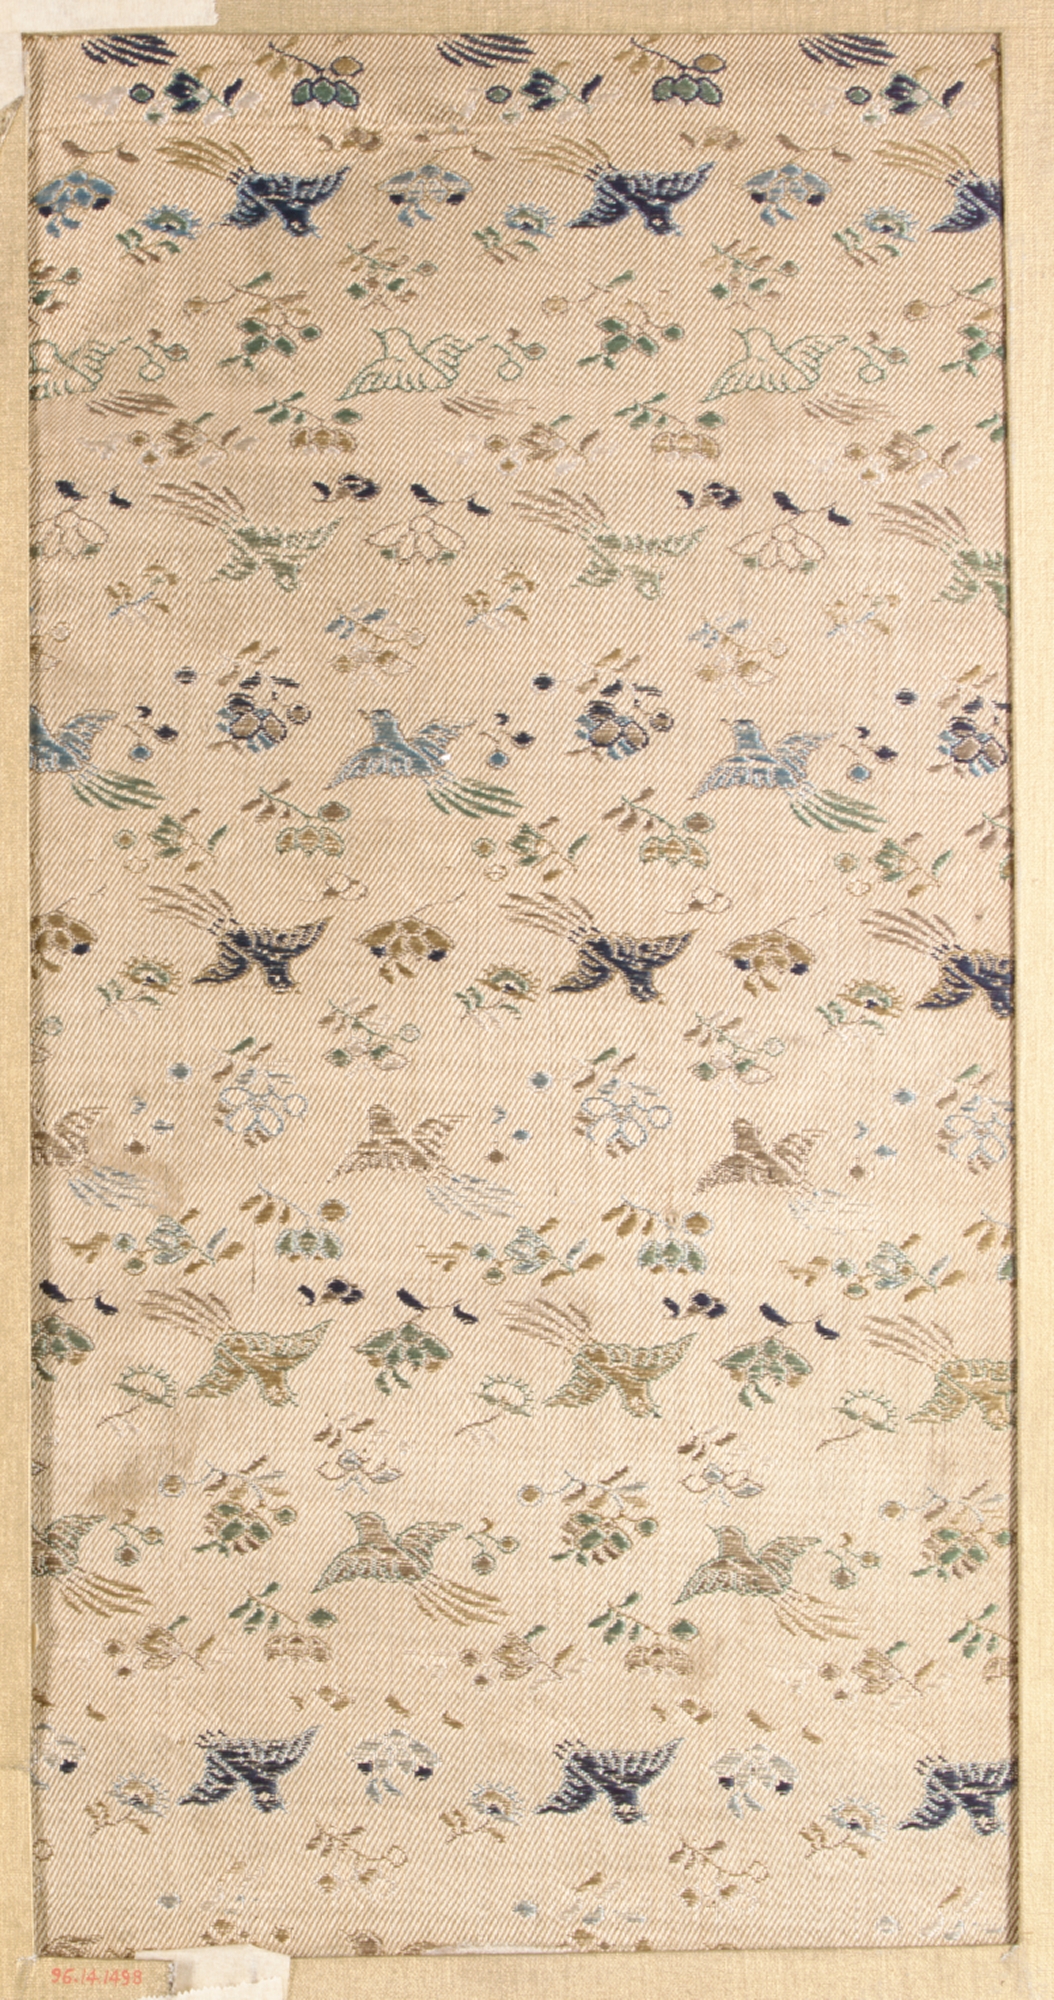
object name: piece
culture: japanese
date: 1701-1900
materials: silk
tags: flowers